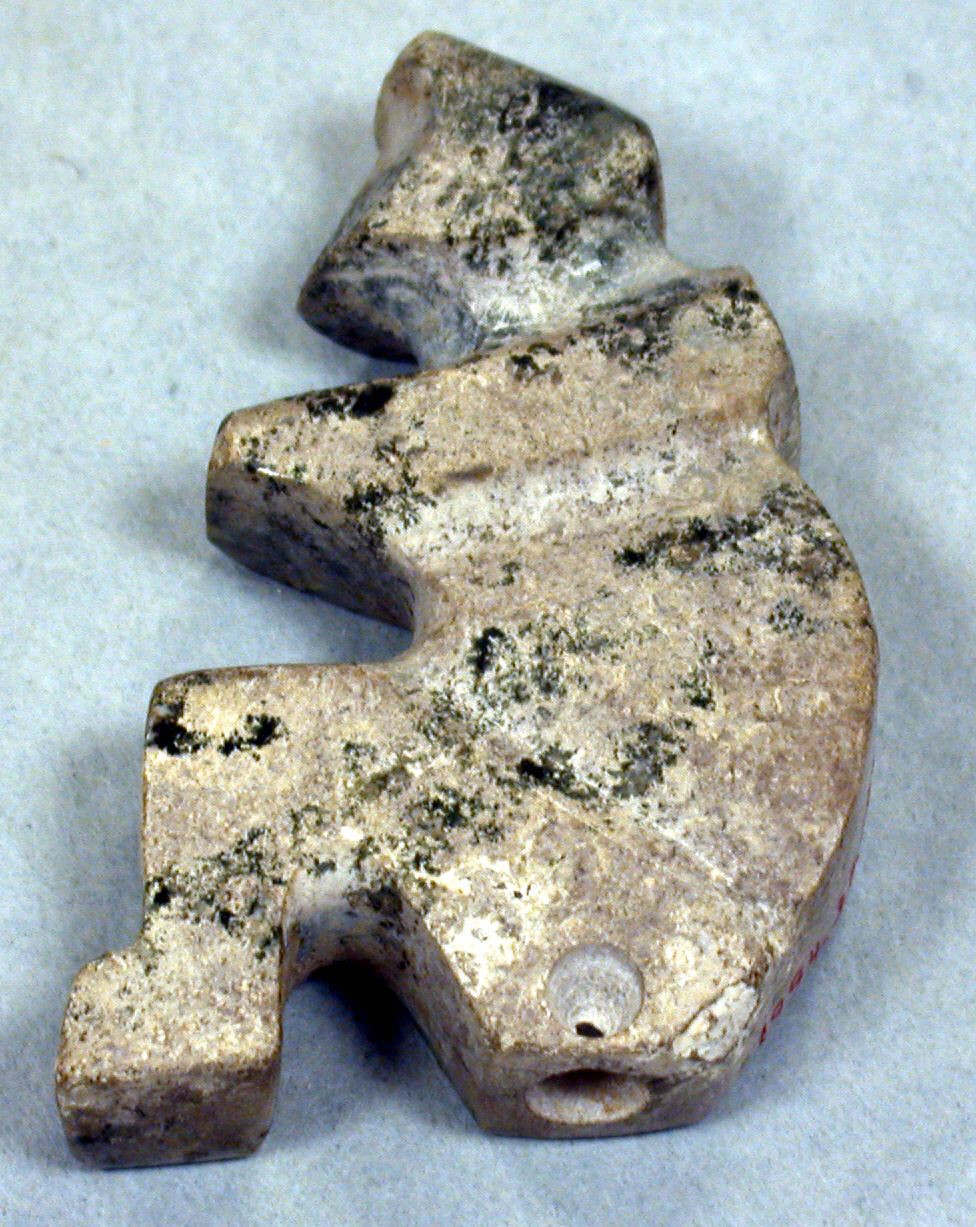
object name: figure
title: Stone Figure Cutout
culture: mezcala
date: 1-800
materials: stone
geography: mexico